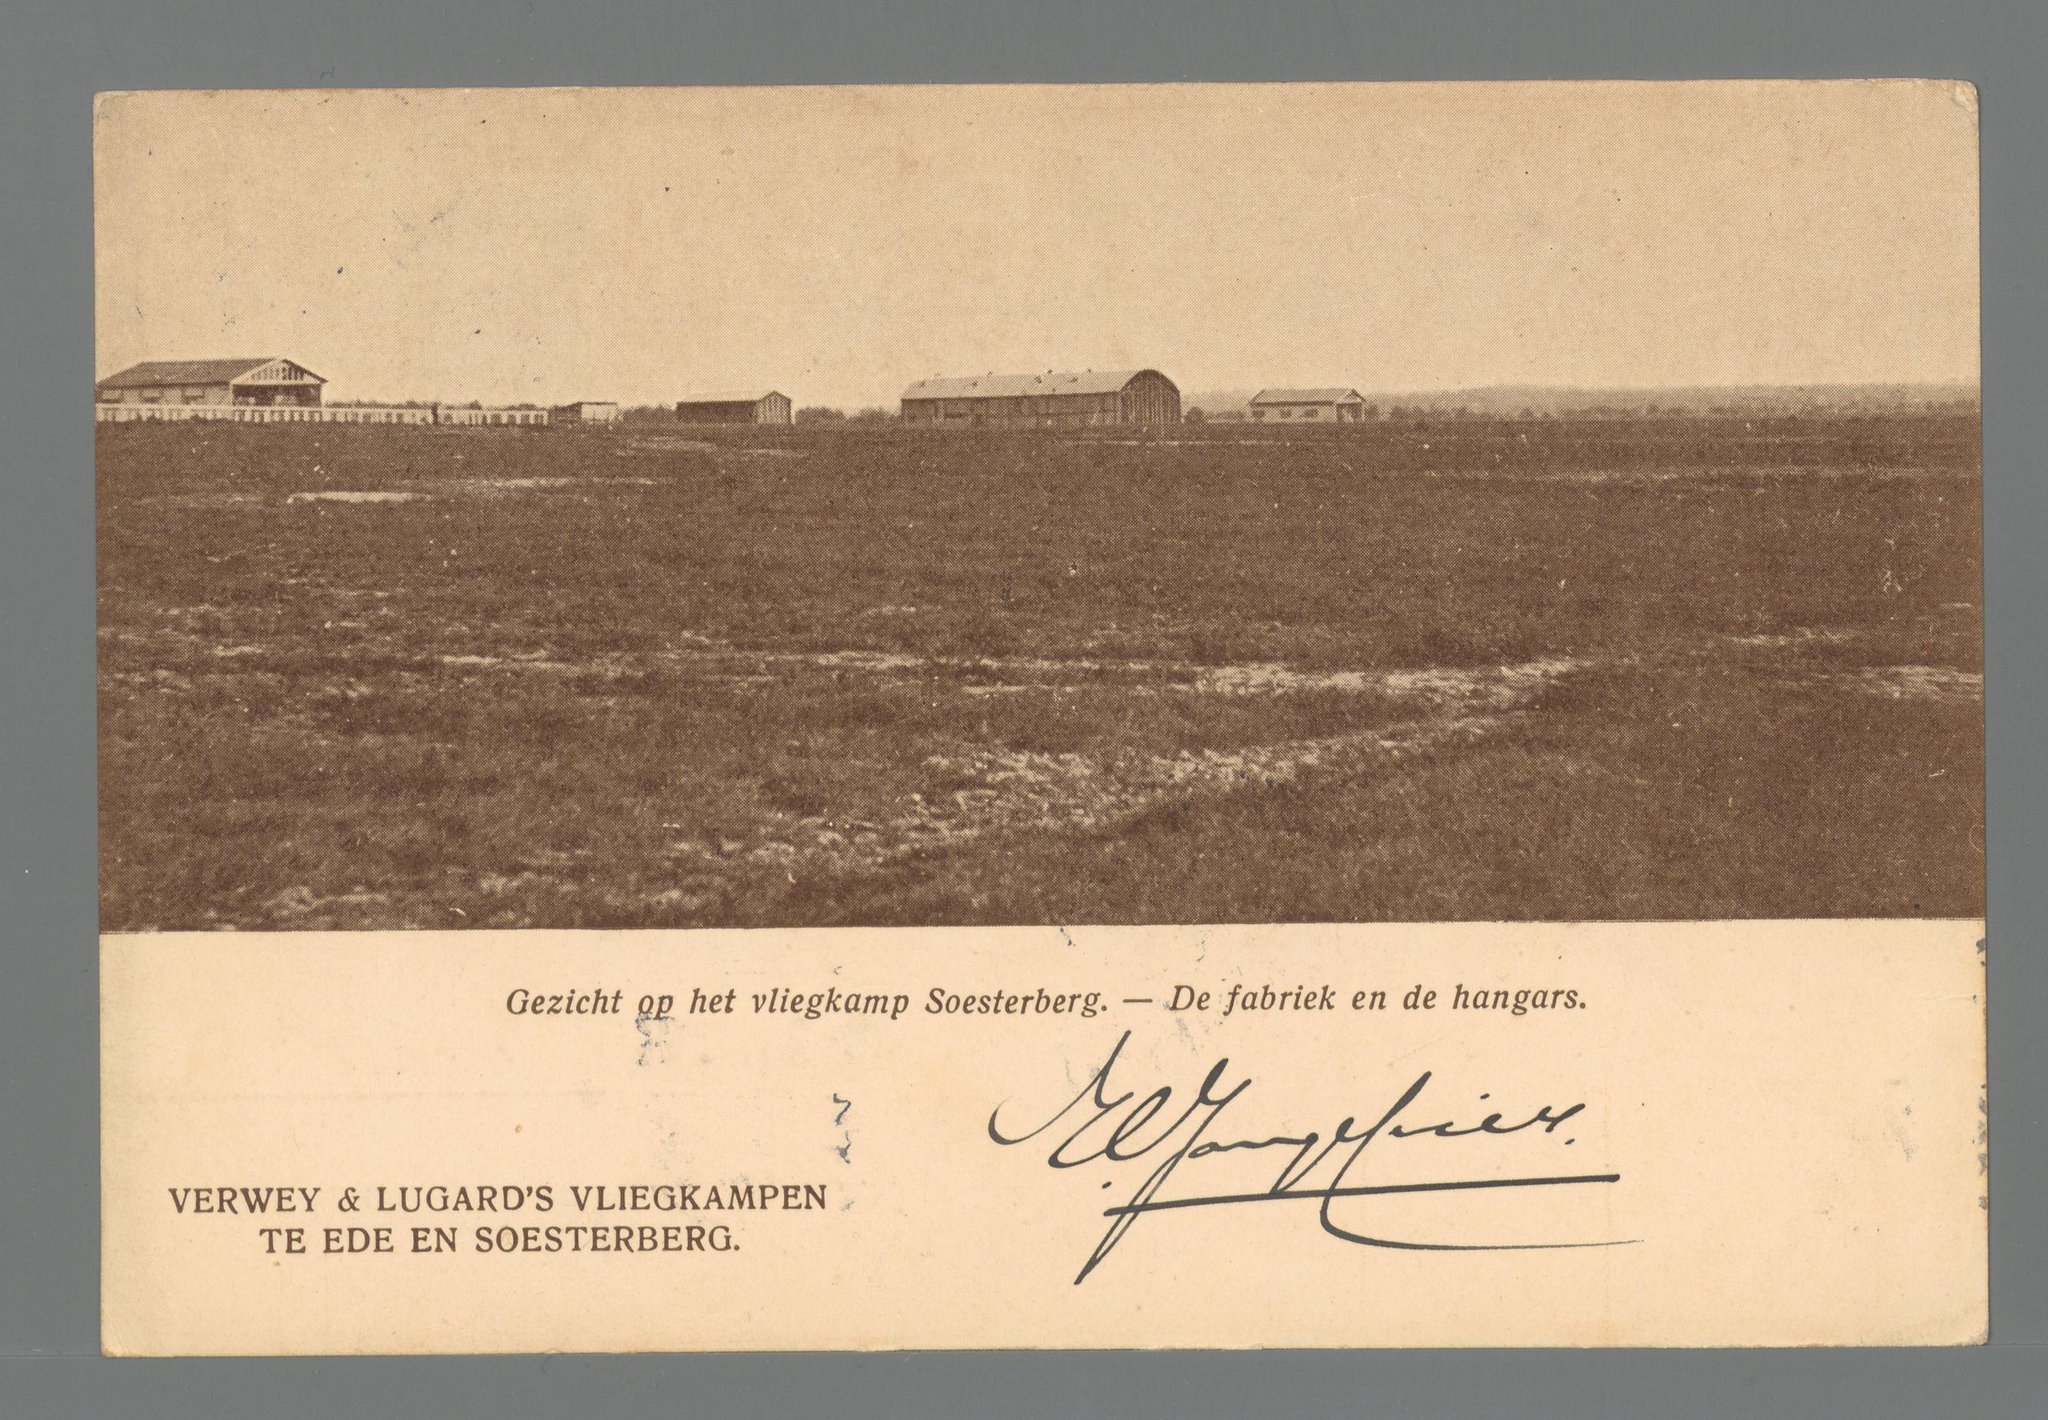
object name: photomechanical print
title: Gezicht op het vliegkamp Soesterberg. - De fabriek en de hangars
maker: Anonymous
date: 1905-1911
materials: cardboard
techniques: writing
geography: soesterberg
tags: factory-building, airfield, airport, hangar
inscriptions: postage stamp